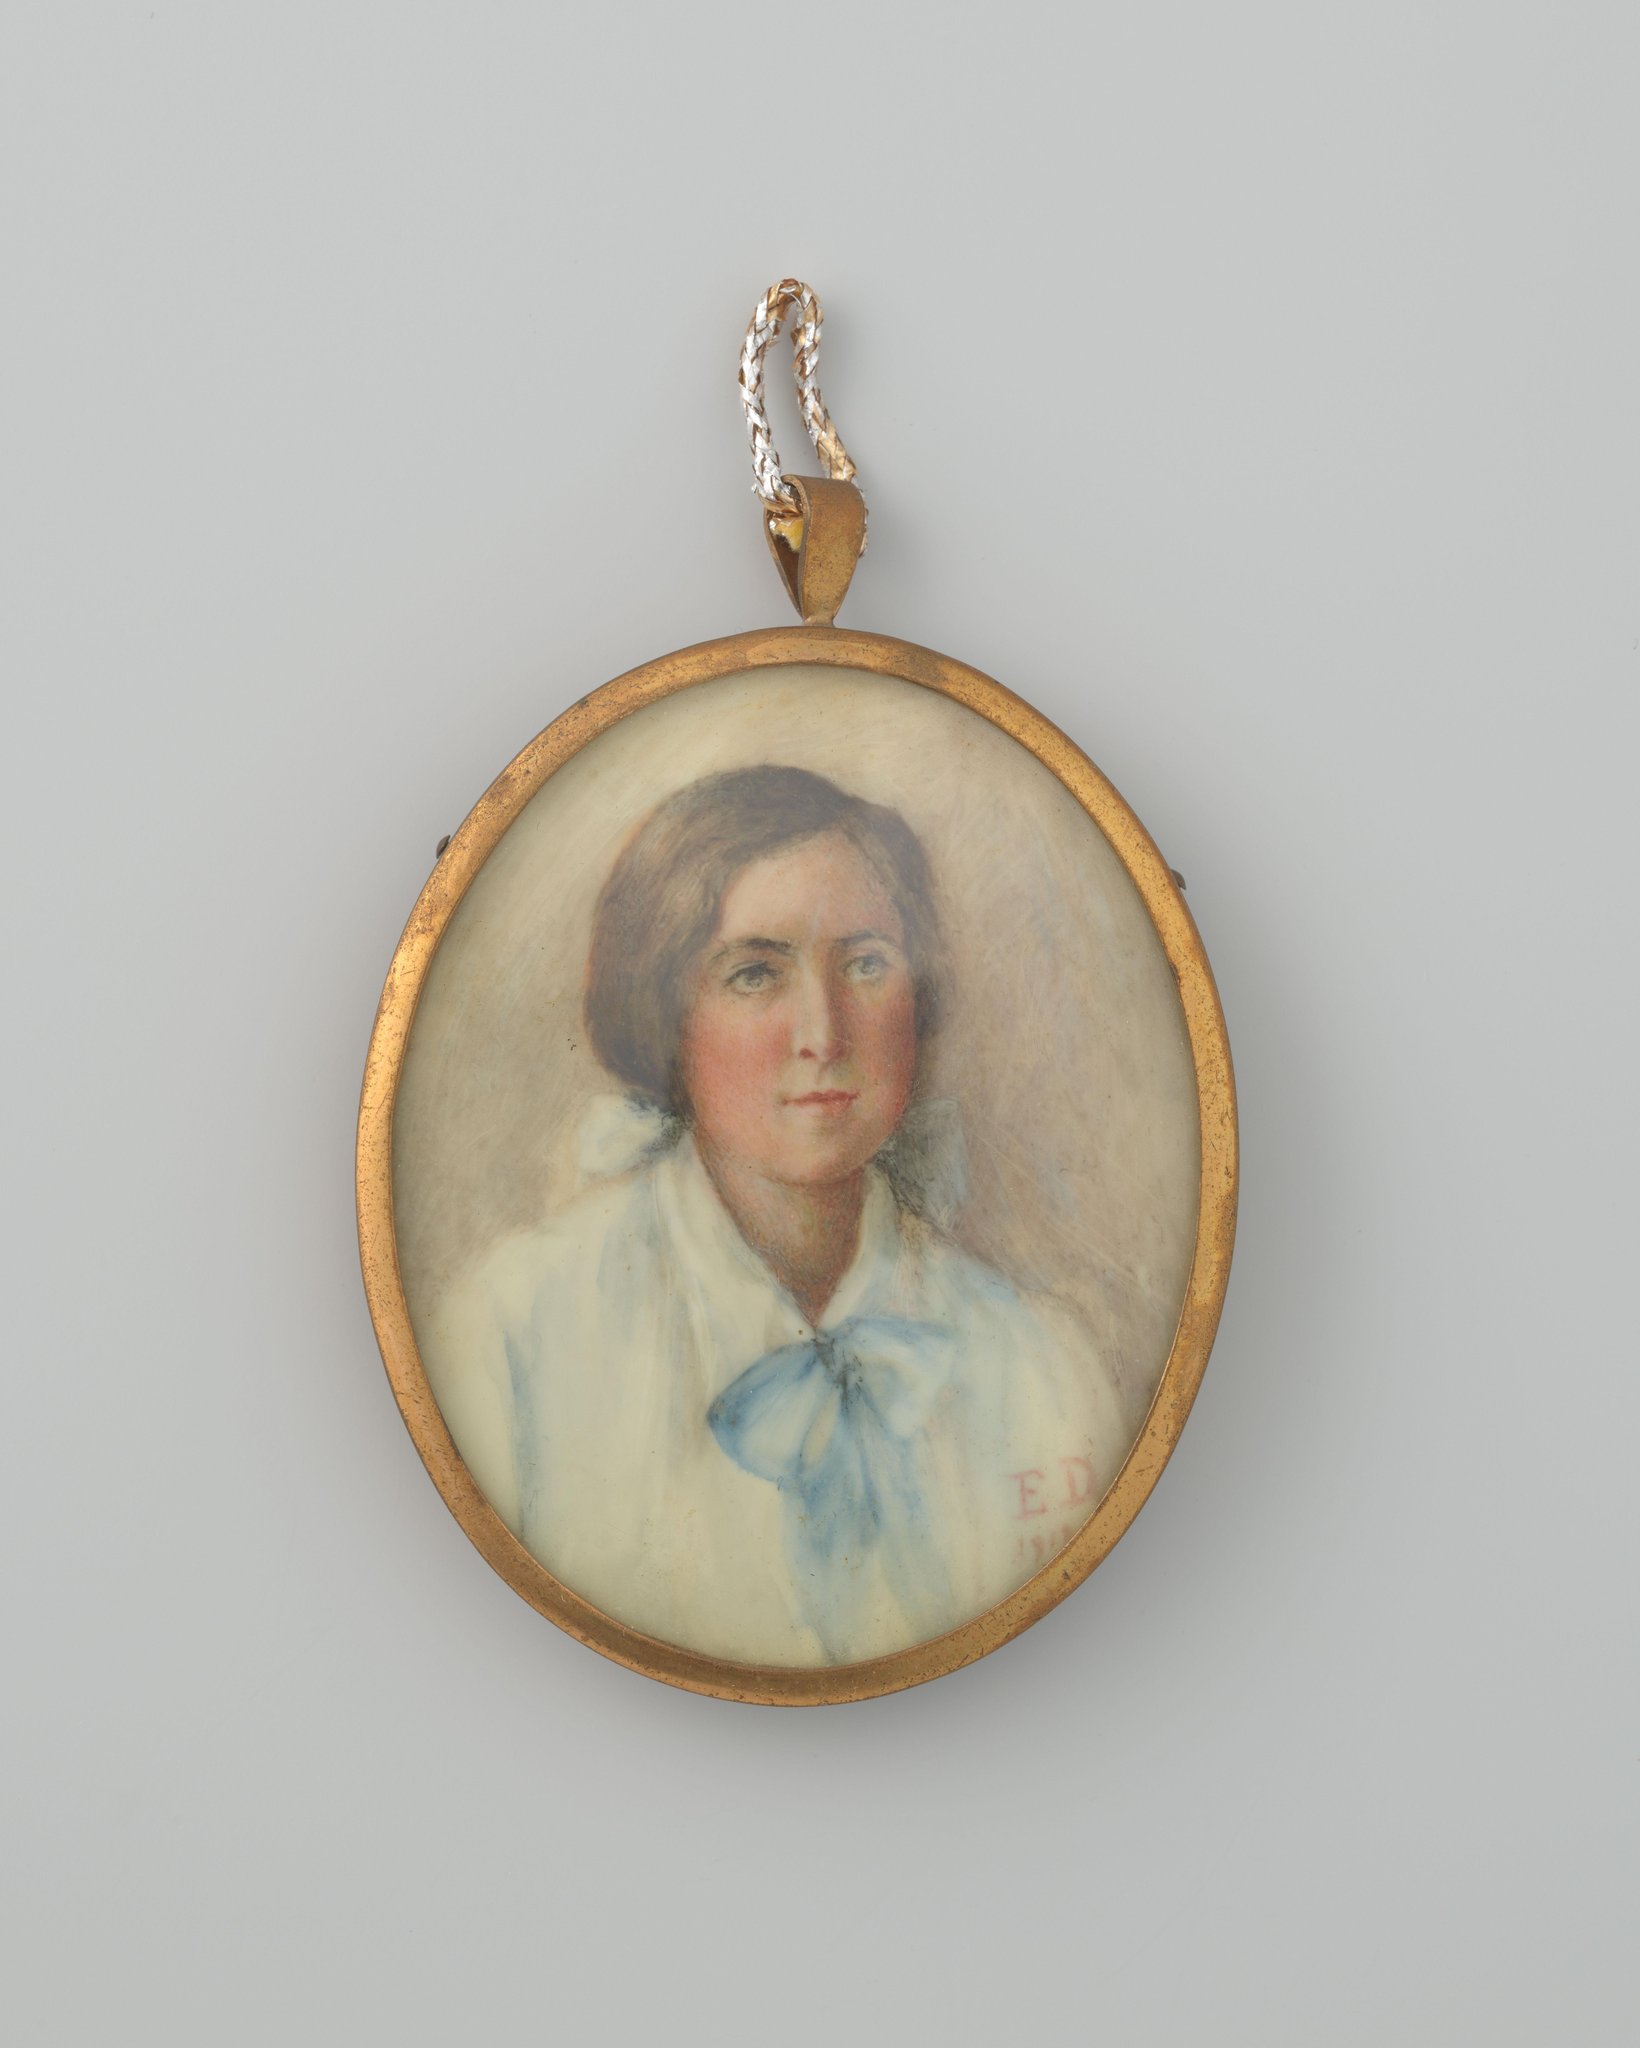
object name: pastel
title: Portret, pastel, van een jonge vrouw, gevat in ovaalvormig montuur (hanger?)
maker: Anonymous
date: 1912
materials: pastel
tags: eugen wachenheimer, else wachenheimer-moos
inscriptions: date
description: Dit object is onderdeel van de nalatenschap van Isabel Elon-Wachenheimer (1928-2010). Tot haar overlijden behoorde het samen met de andere objecten uit de nalatenschap tot haar privédomein van Isabel Wachenheimer. In die particuliere context zijn deze objecten tezamen en individueel aandenkens - aan de jeugd, ouders en familie van Isabel Wachenheimer vóór en tijdens de Shoah en aan haar leven na de Tweede Wereldoorlog. Isabel Wachenheimer, die van juni 1943 tot mei 1945 gevangen zat in Kamp Westerbork, Theresienstadt, Auschwitz, Lenzing a/d Oberdonau (een buitenkamp van Mauthausen), overleefde de Shoah. Haar ouders – Eugène Wachenheimer en Else Wachenheimer-Moos - werden op 14 oktober 1944 in Auschwitz-Birkenau vermoord.